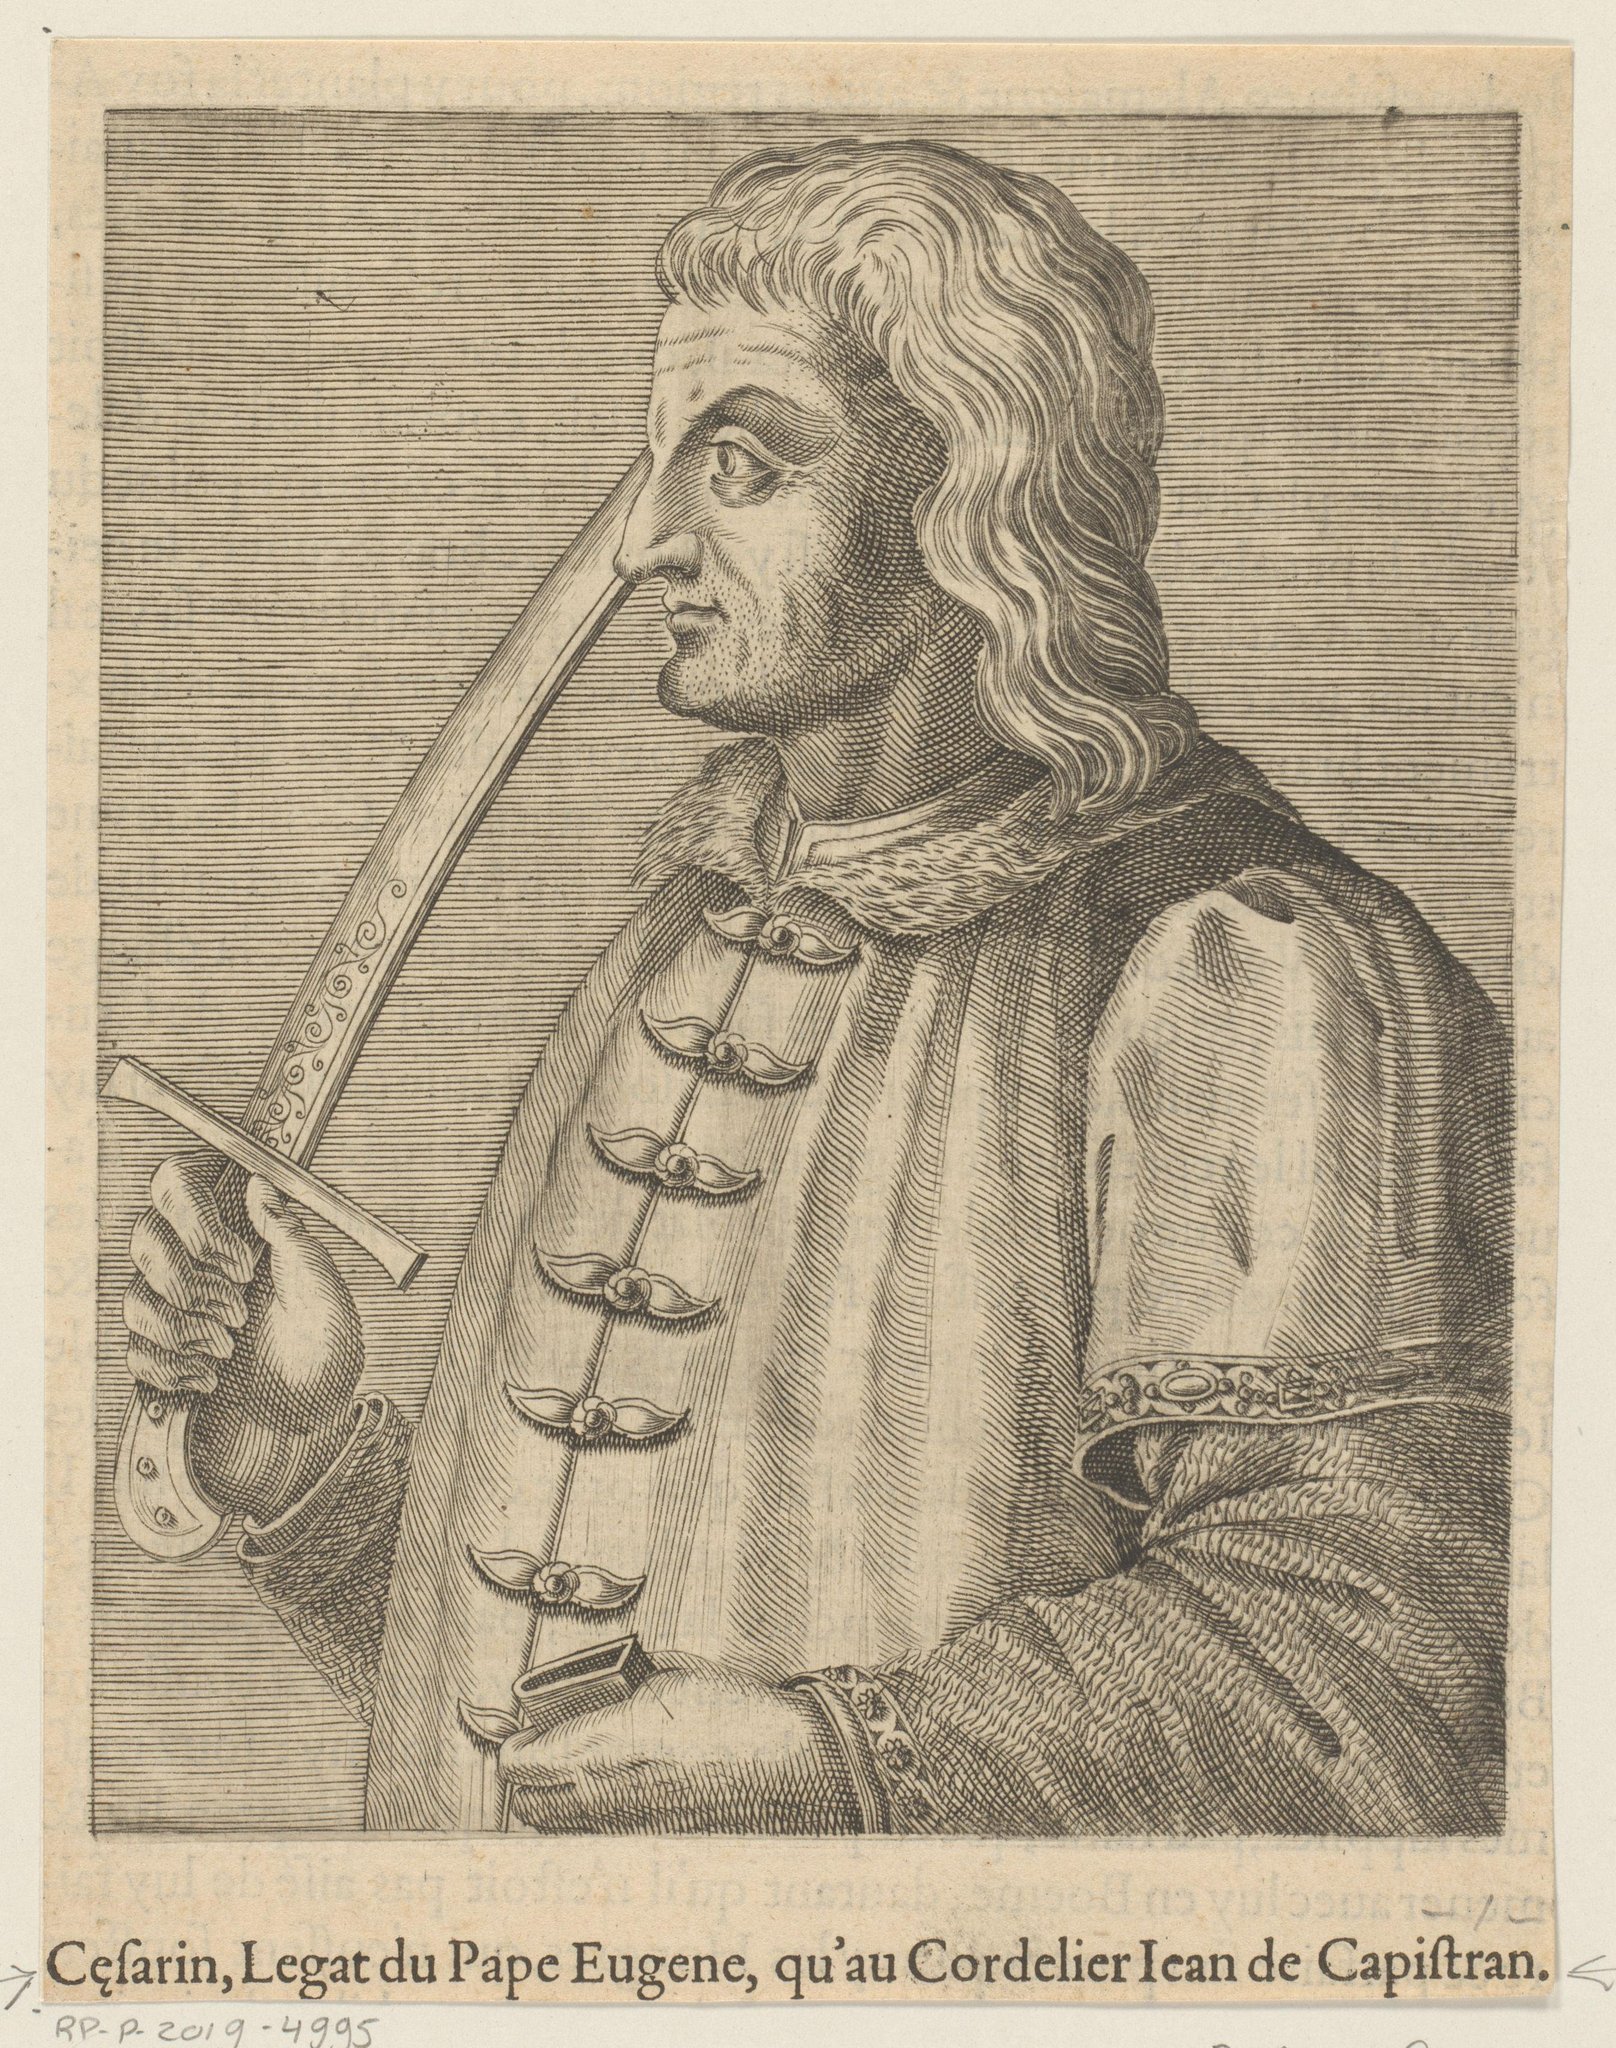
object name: book illustration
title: Portret van Matthias Corvinus, koning van Hongarije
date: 1584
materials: paper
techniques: engraving, etching, letterpress printing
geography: paris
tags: vienna, historical persons, hacking and thrusting weapons: sword, king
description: Prent uit: Thevet, André. Les vrais pourtraits et vies des hommes illustres grecz, latins et payens (...). Parijs: weduwe Jacques Kerver en Guillaume Chaudière, 1584, dl. 2, f. 319.